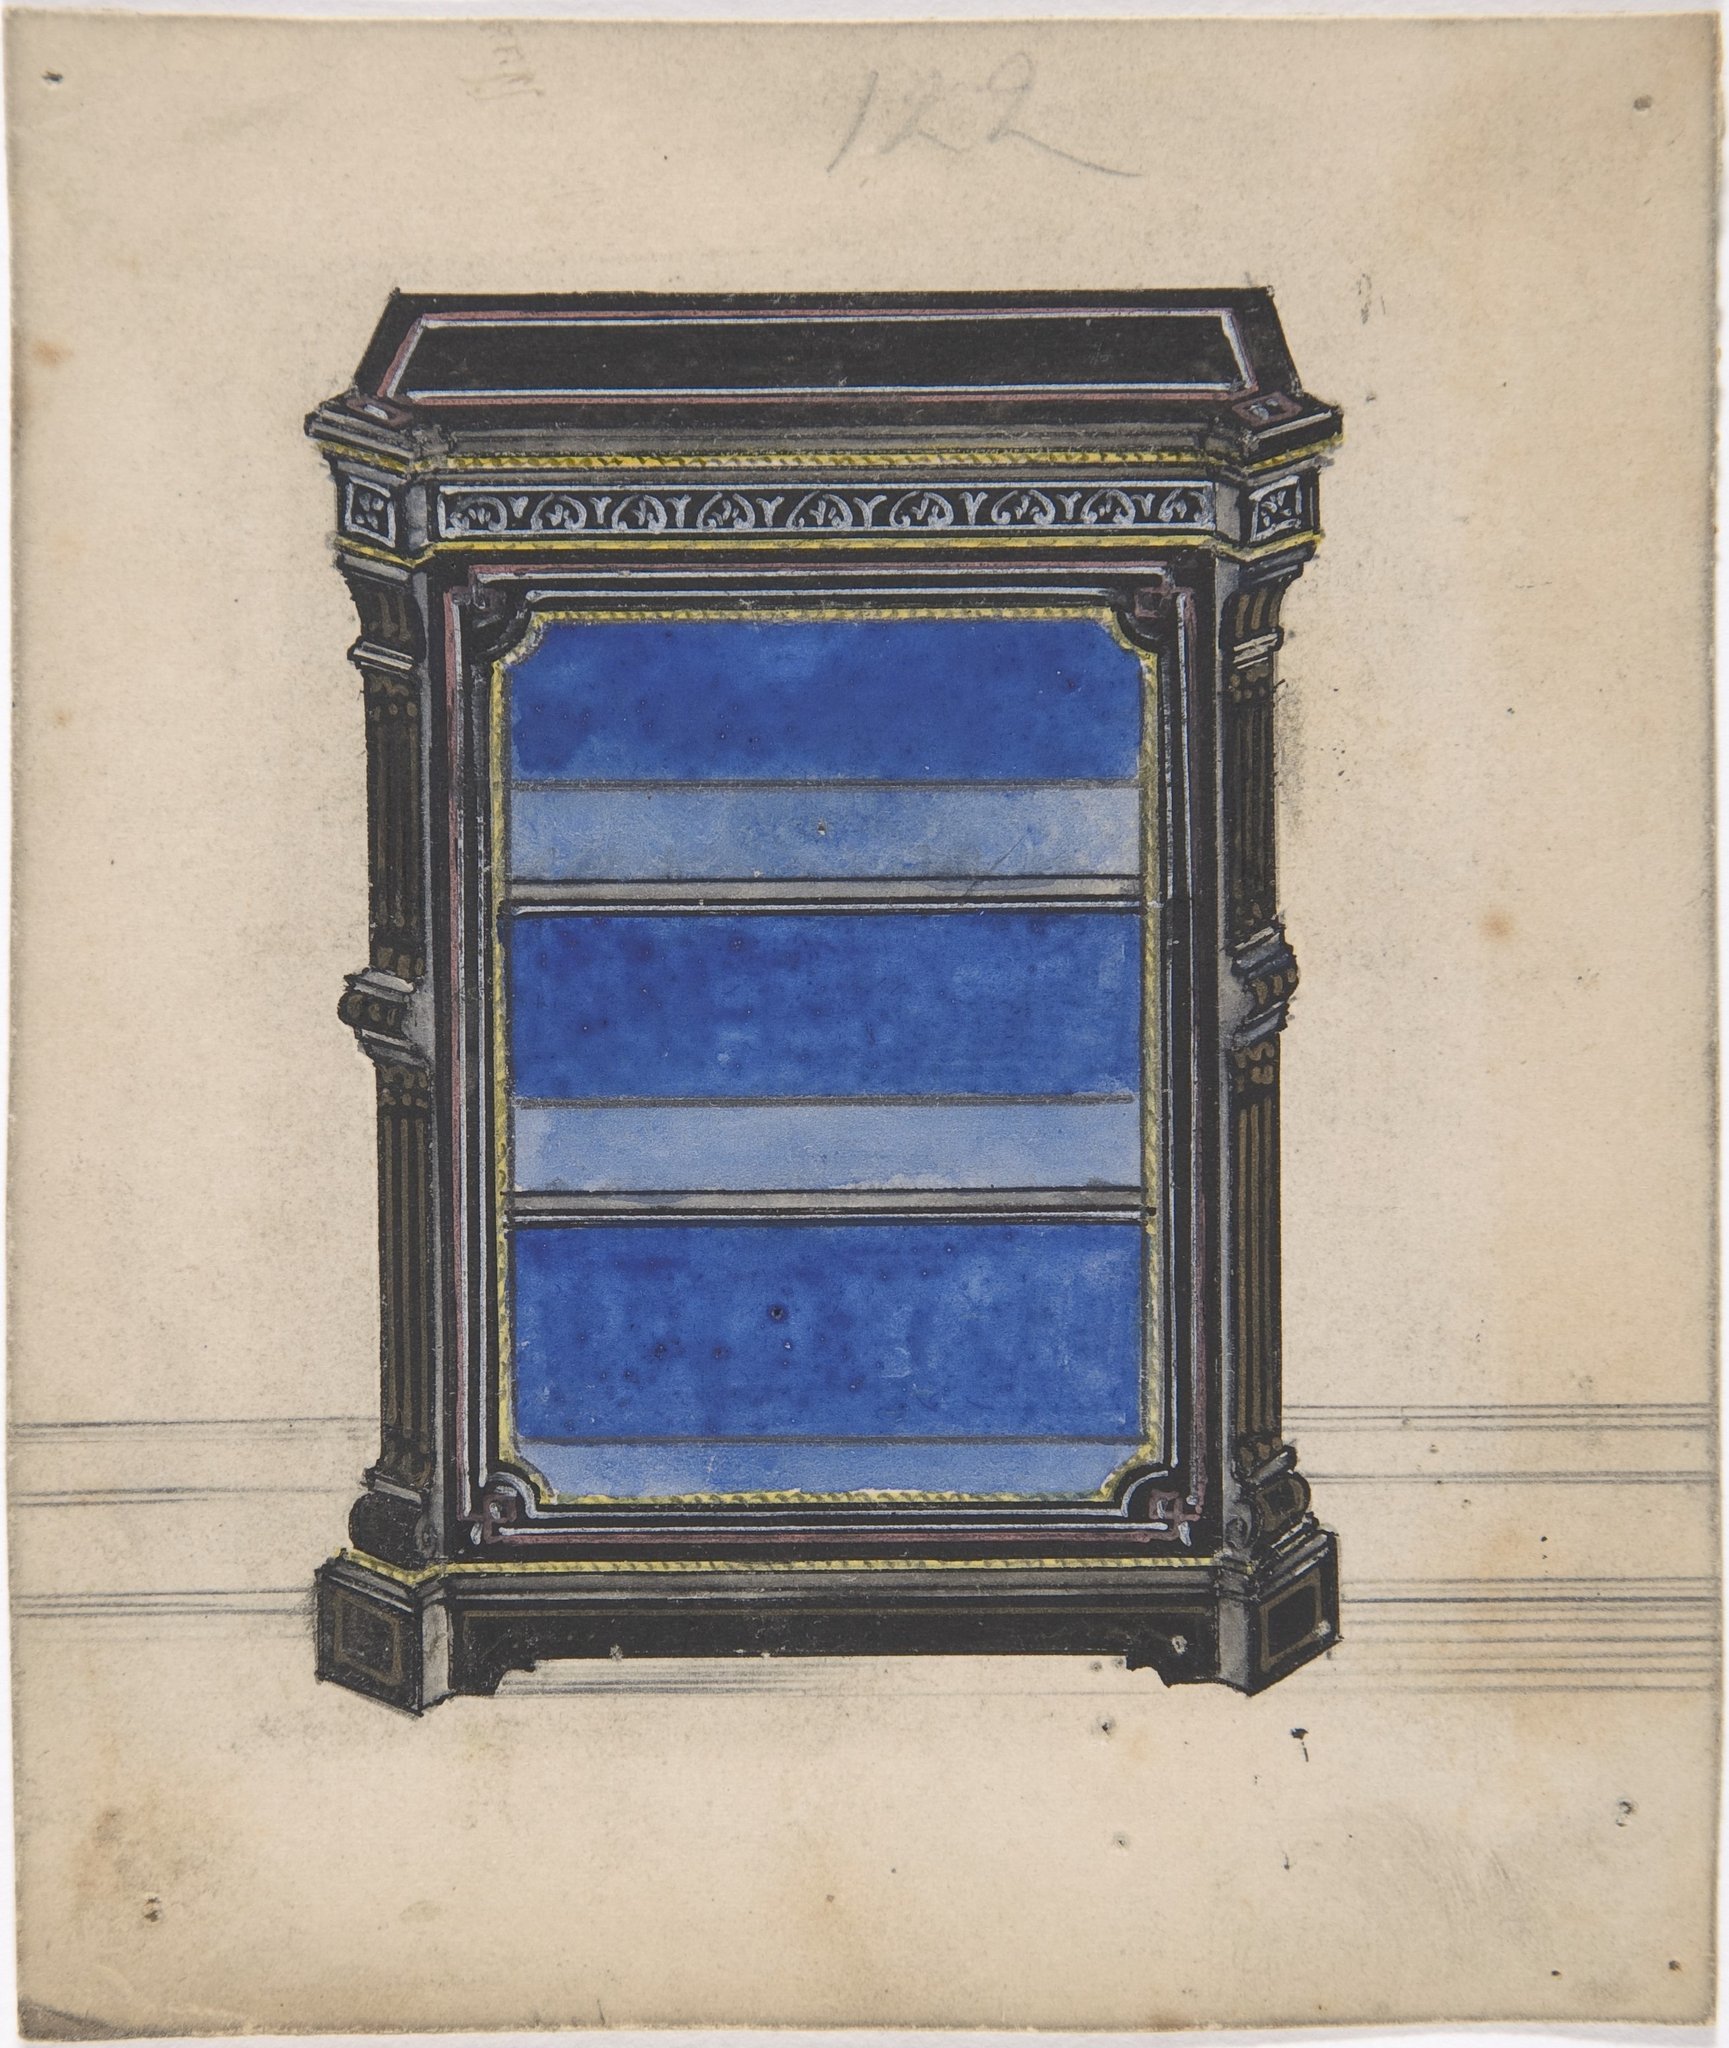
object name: drawing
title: Design for a Black Cabinet with a Blue Interior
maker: anonymous, british, 19th century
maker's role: artist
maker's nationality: british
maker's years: 1800-1900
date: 1801-1900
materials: ink, watercolor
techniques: pen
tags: cabinets